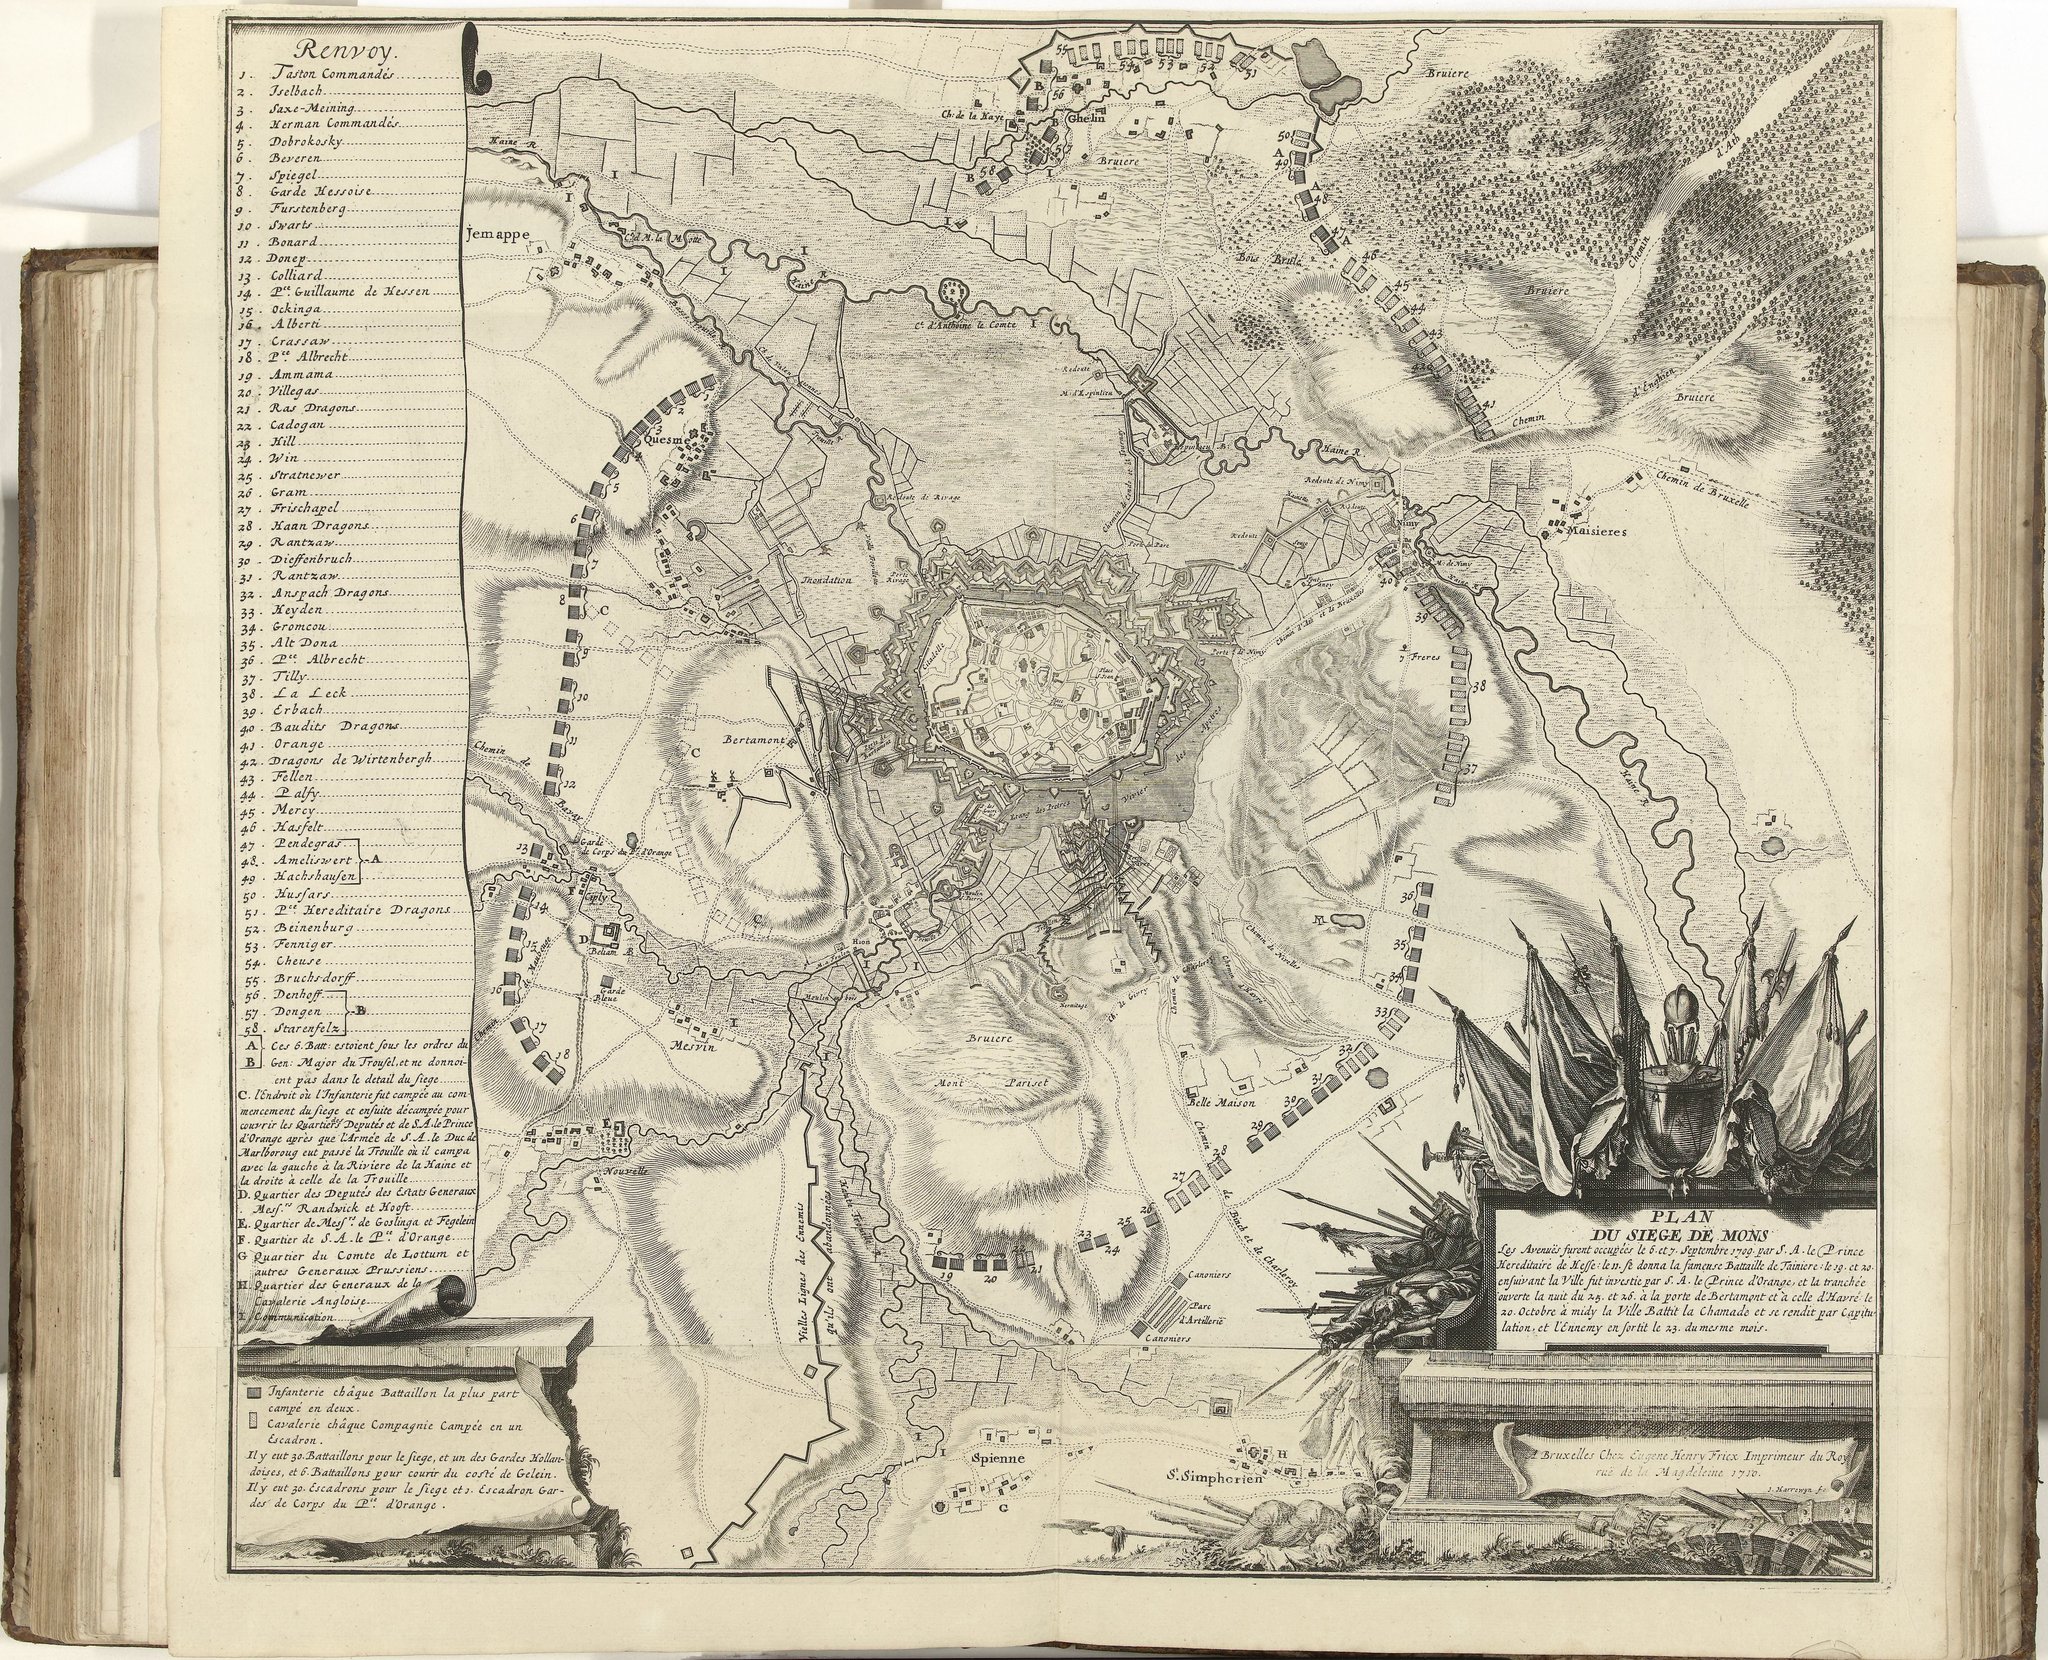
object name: print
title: Beleg van Mons, 1709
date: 1710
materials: paper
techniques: engraving, etching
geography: brussels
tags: maps of separate countries or regions, siege, position war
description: Kaart van het beleg en inname van Mons (Bergen) door de Geallieerden, 25 september - 22 oktober 1709. Rechtsonder een cartouche met de titel, versierd met wapens, vaandels en enkele lichamen van verslagen vijandelijke soldaten. Aan de linkerzijde de verklaring 1-58 en A-I in het Frans. Onderdeel van een gebundelde verzameling van plannen van veldslagen en steden vermaard in de Spaanse Successieoorlog.